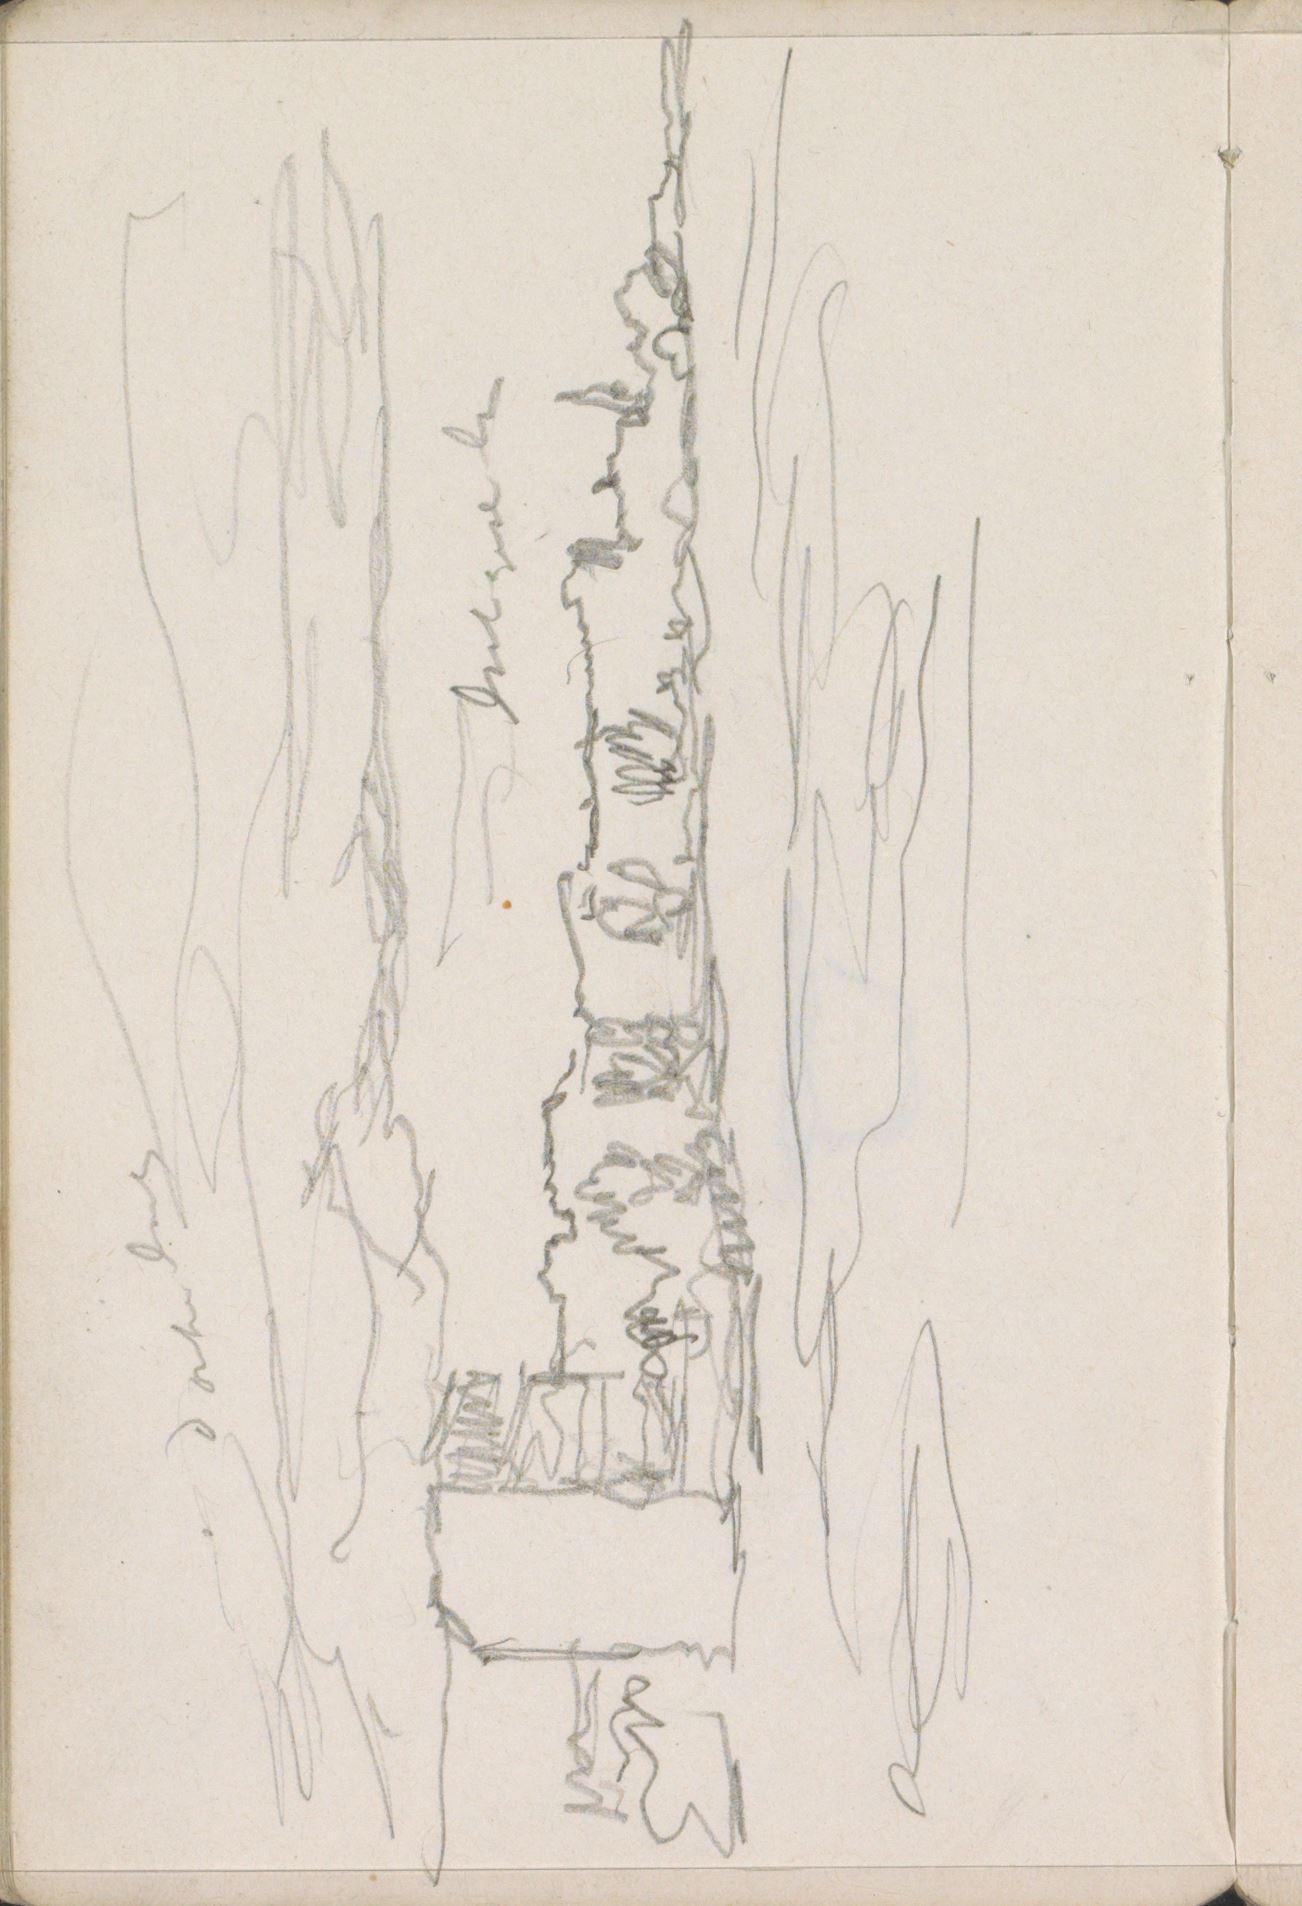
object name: sketchbook leaf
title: Landschap met bebouwing, mogelijk aan het water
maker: george hendrik breitner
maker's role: draughtsman, painter, print maker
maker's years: 1857-1923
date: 1917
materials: paper, pencil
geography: amsterdam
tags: landscapes with waters, waterscapes, seascapes (in the temperate zone), civic architecture; edifices; dwellings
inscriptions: kleurnotitie, handgeschreven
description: Pagina 11 uit een schetsboek met 44 bladen.